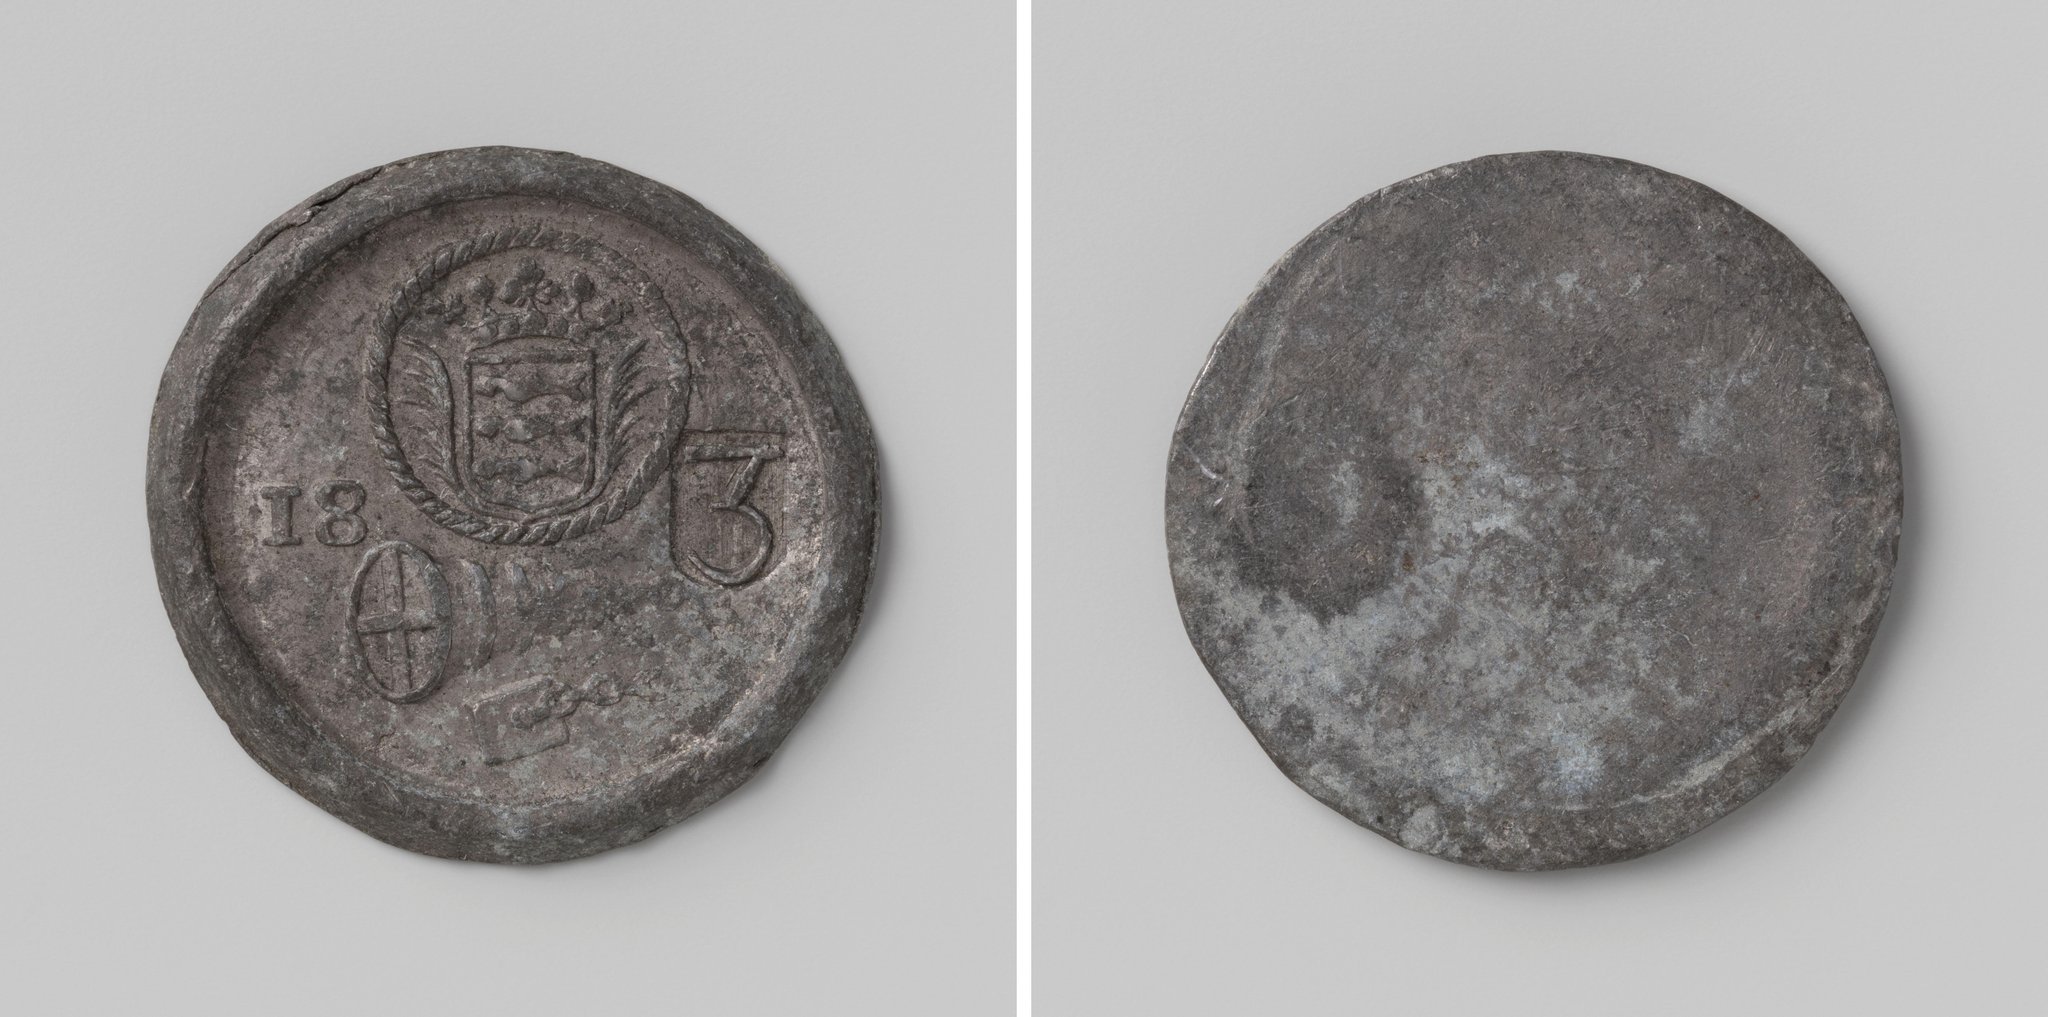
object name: tonnegeld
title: Stad Enkhuizen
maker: Anonymous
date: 1803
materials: lead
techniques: striking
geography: enkhuizen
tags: enkhuizen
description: eenzijdig, niet geheel rond loodje. Voorzijde: gekroond wapenschild op twee gekruiste takken binnen ronde kabelrand; daaronder: stempel tussen jaartal. Keerzijde: blanco